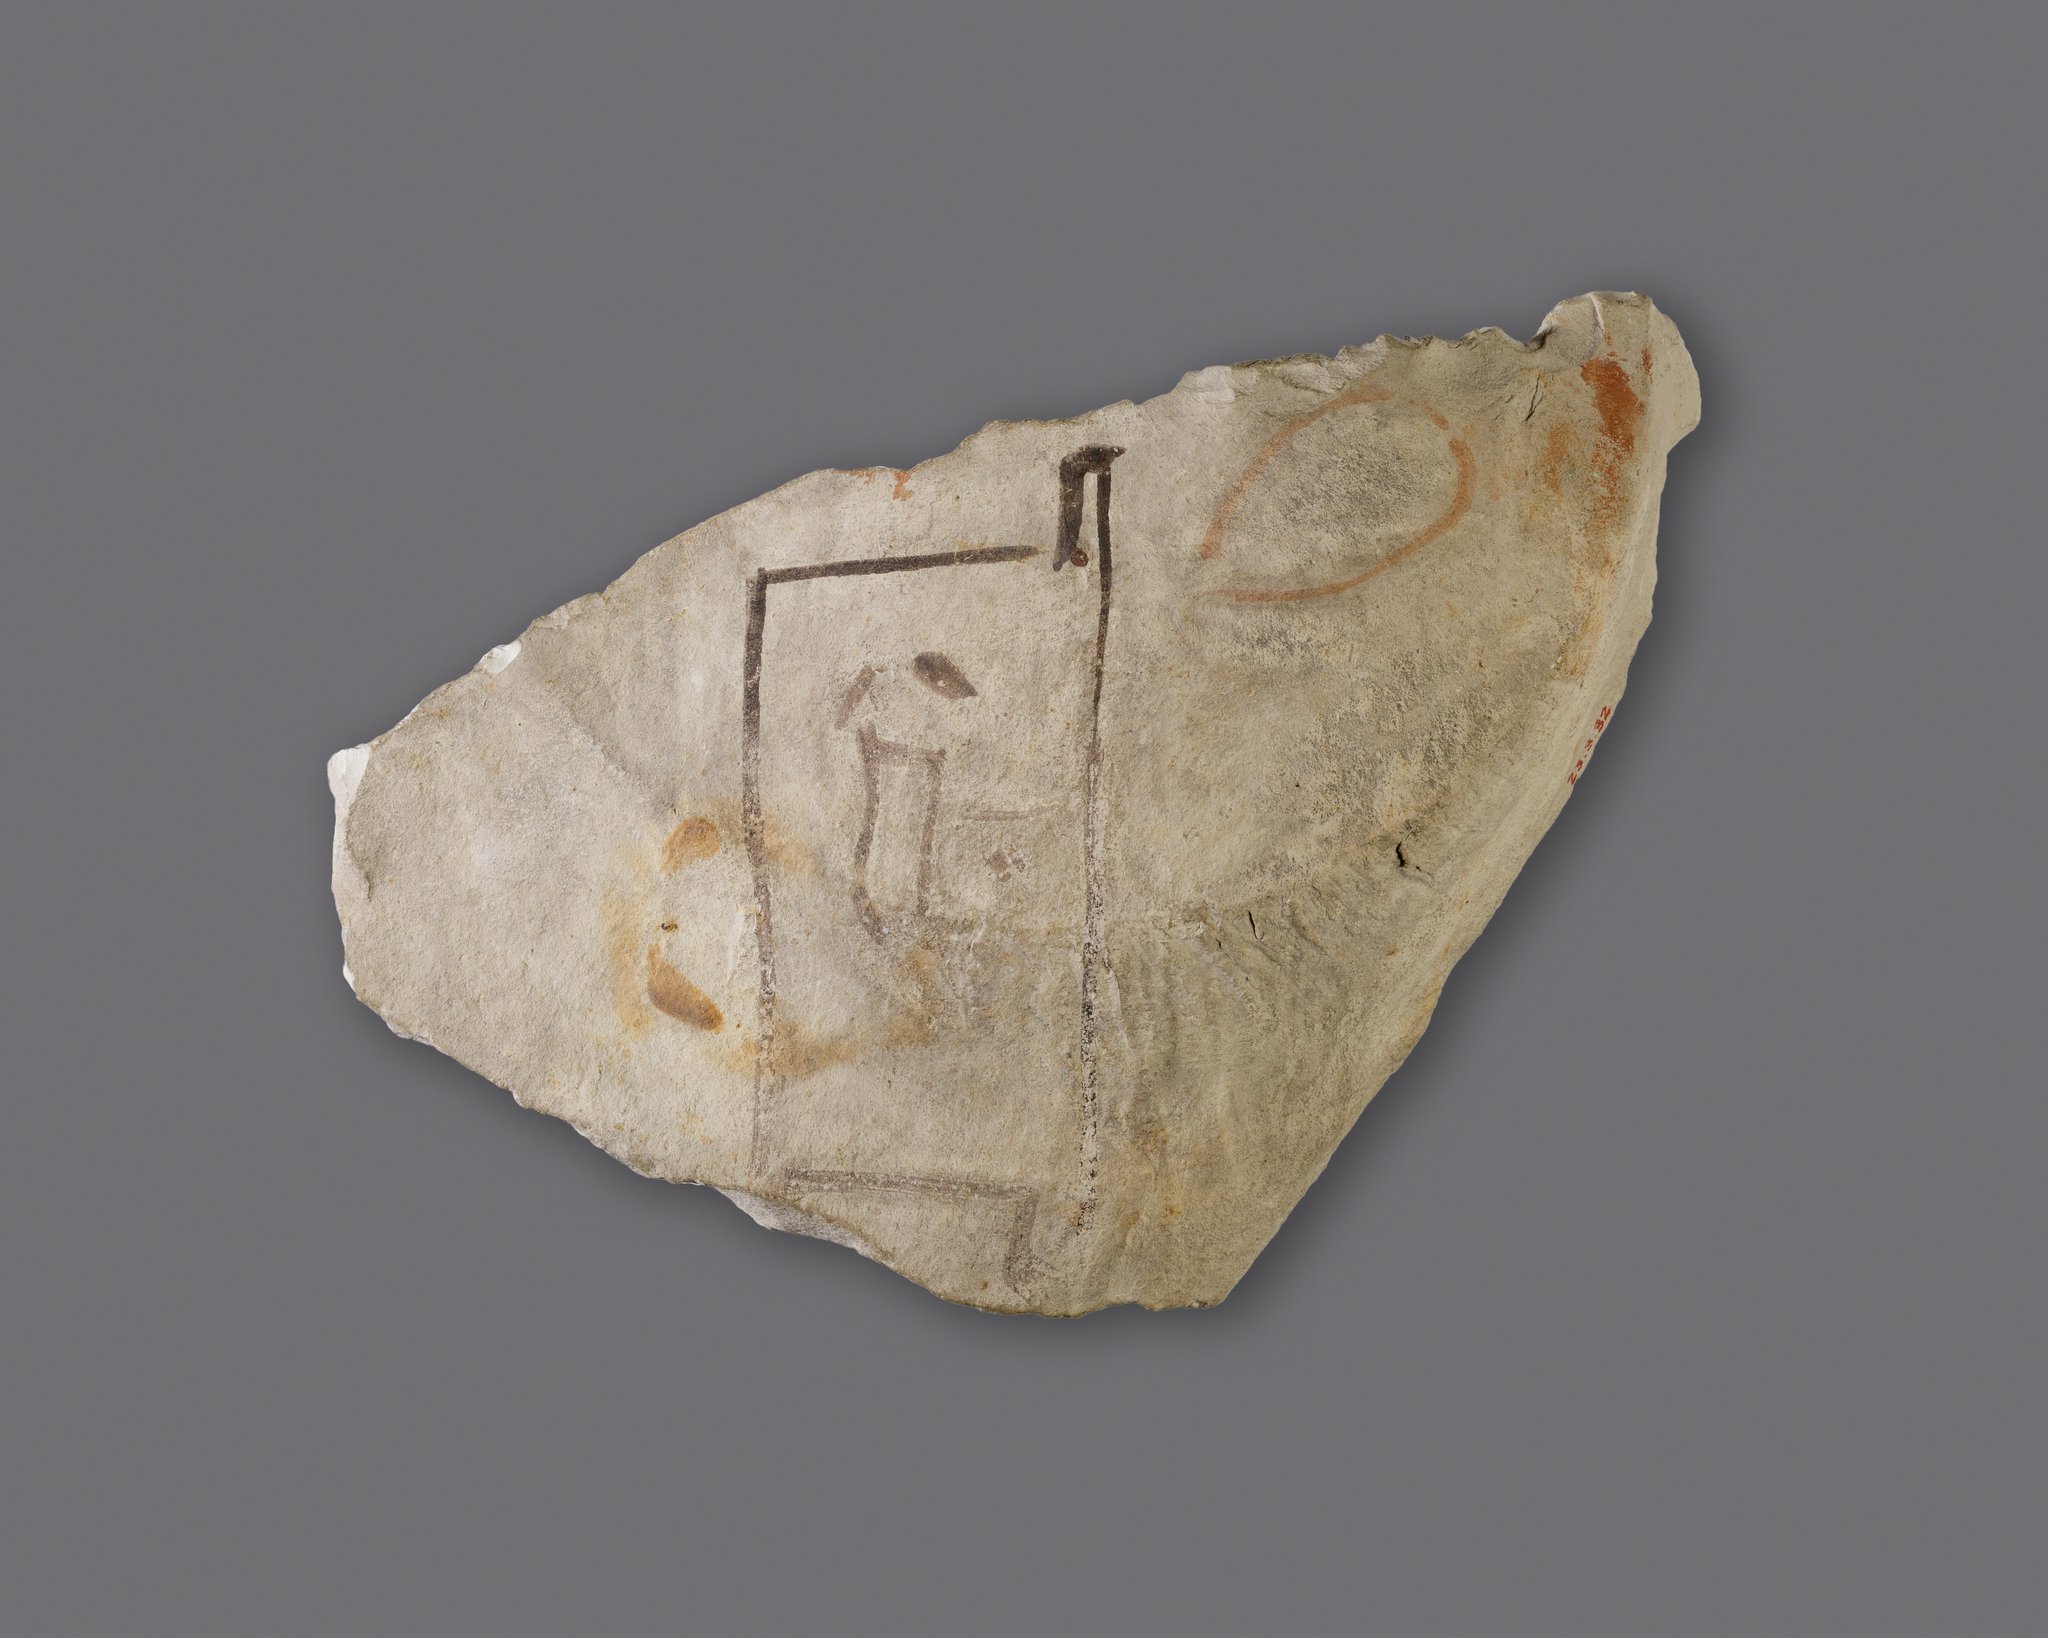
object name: ostracon, figured, door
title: Ostracon with sketch of a door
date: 664-610 BCE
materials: ink, limestone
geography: egypt